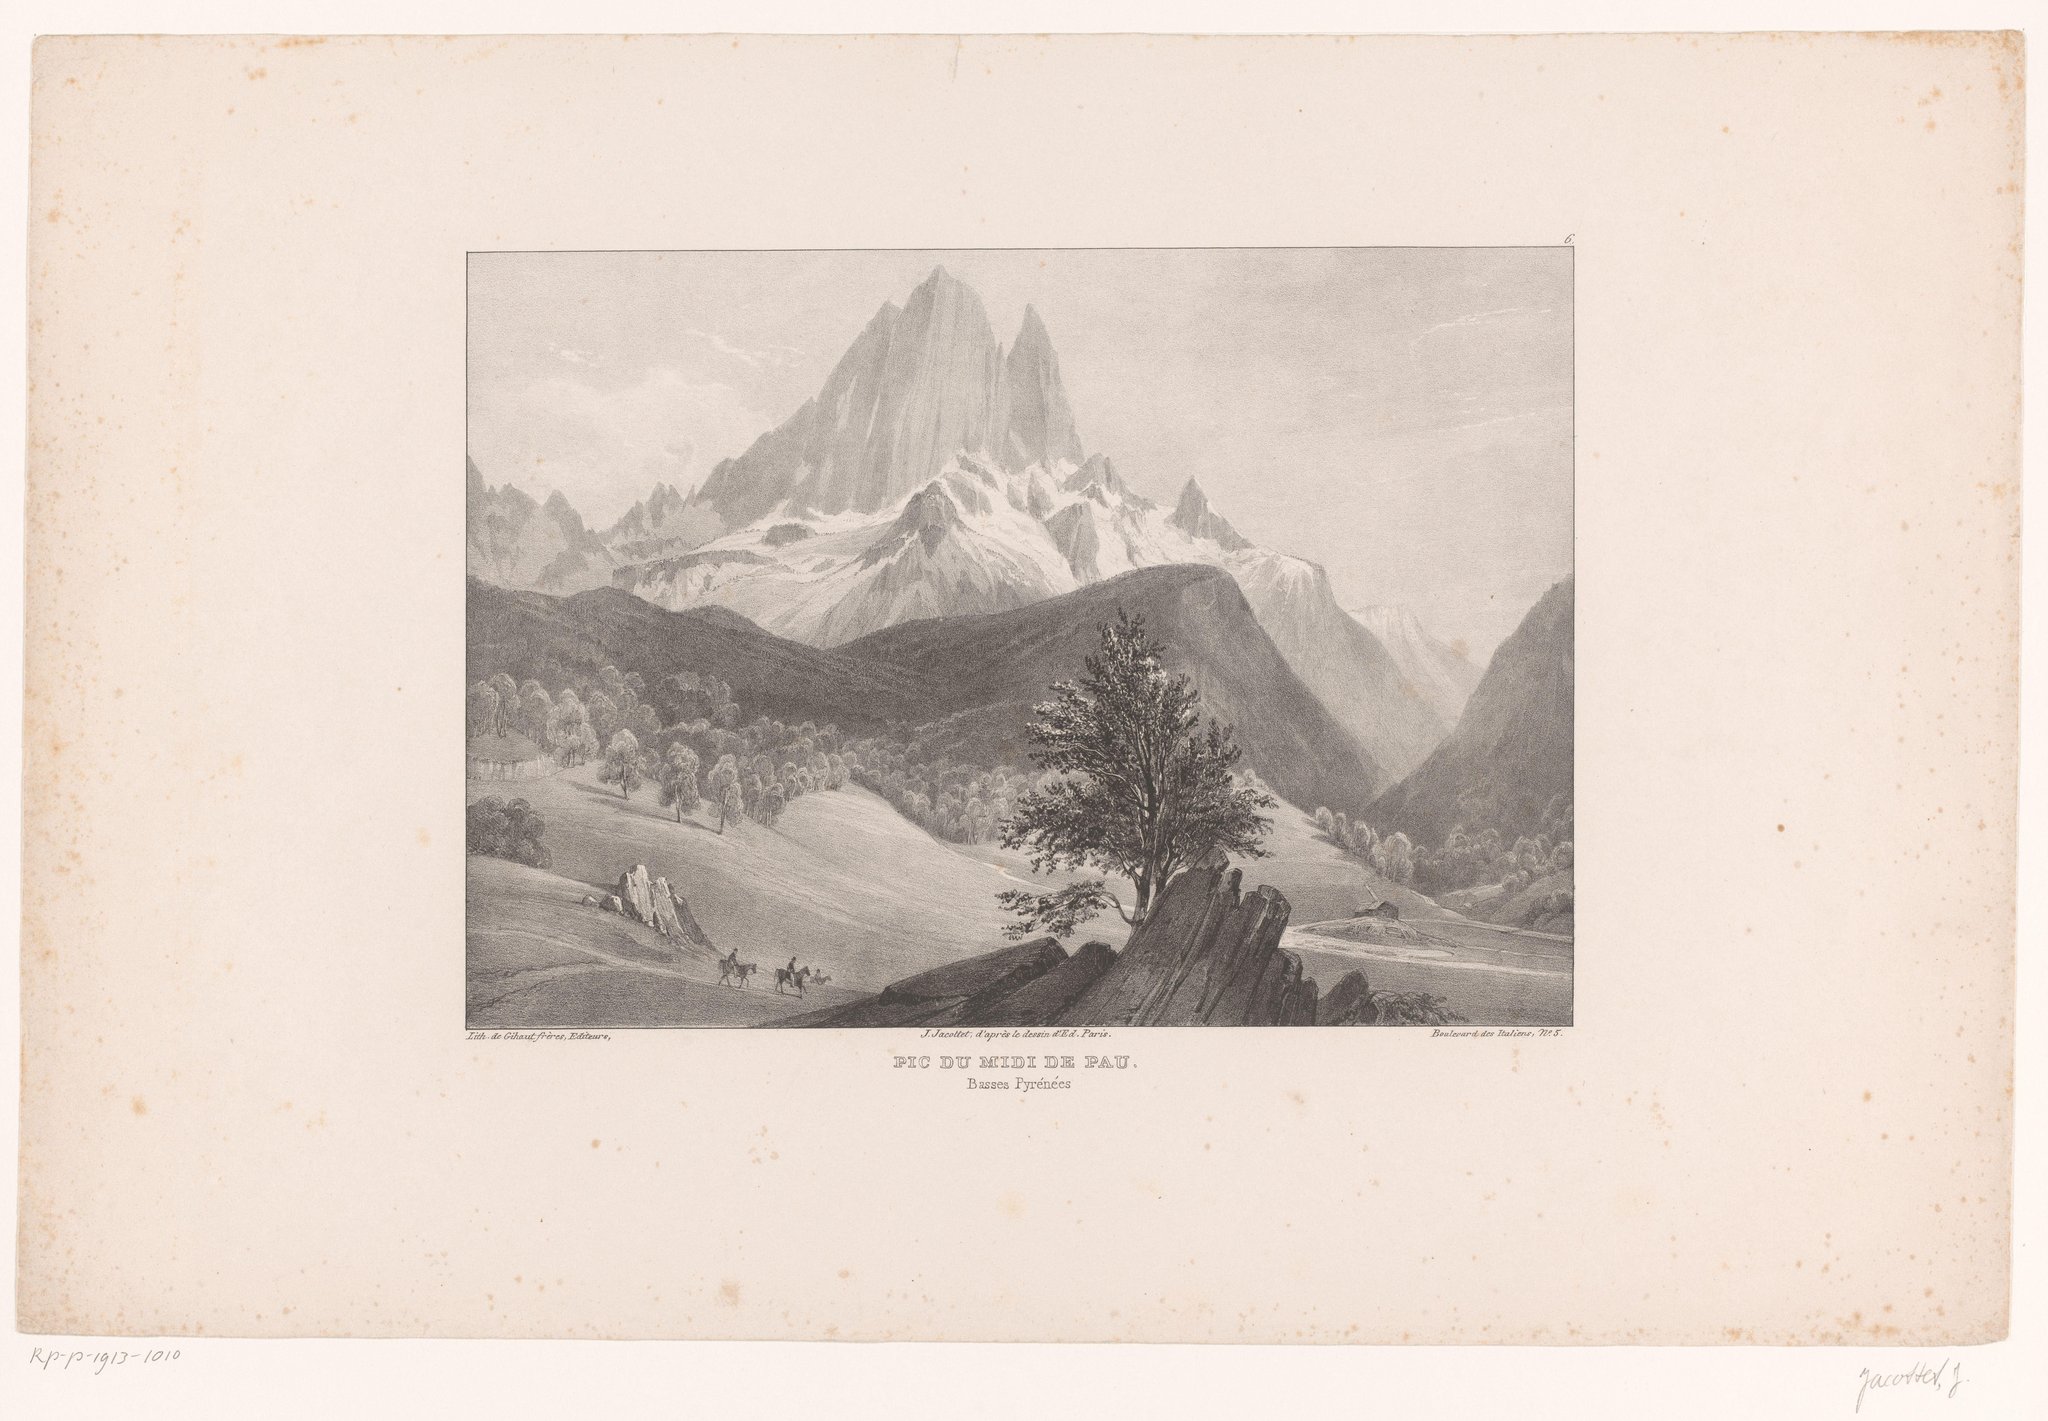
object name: print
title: Basses Pyrénées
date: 1835-1836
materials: paper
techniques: lithograph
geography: paris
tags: mountain-top, peak (+ landscape with figures, staffage)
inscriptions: collector's mark: Lugt 2228a